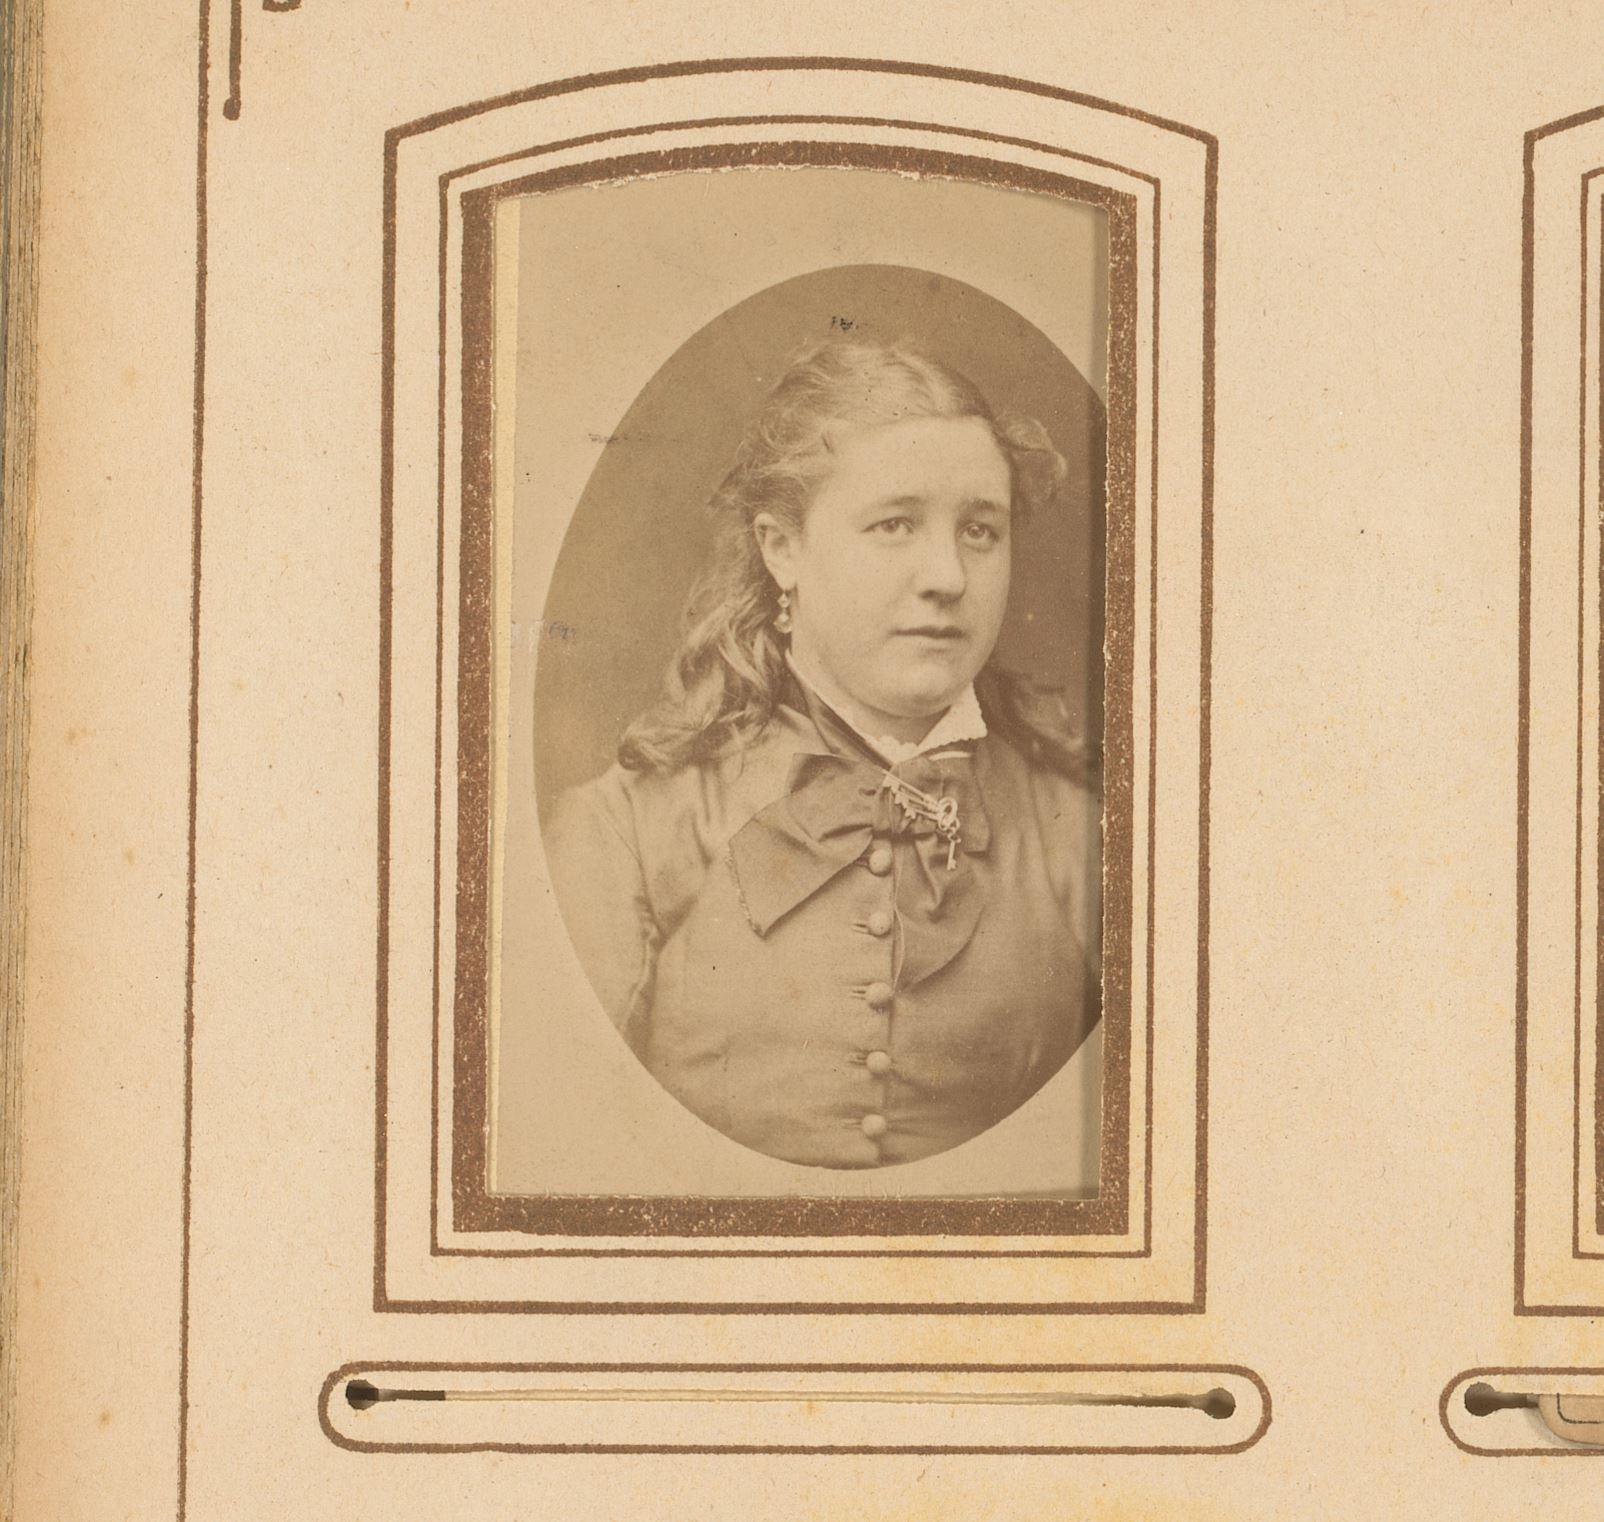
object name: carte de visite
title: Portret van een jonge vrouw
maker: Anonymous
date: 1880-1920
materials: cardboard, photographic support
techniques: albumen print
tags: adolescent, young woman, maiden, historical persons